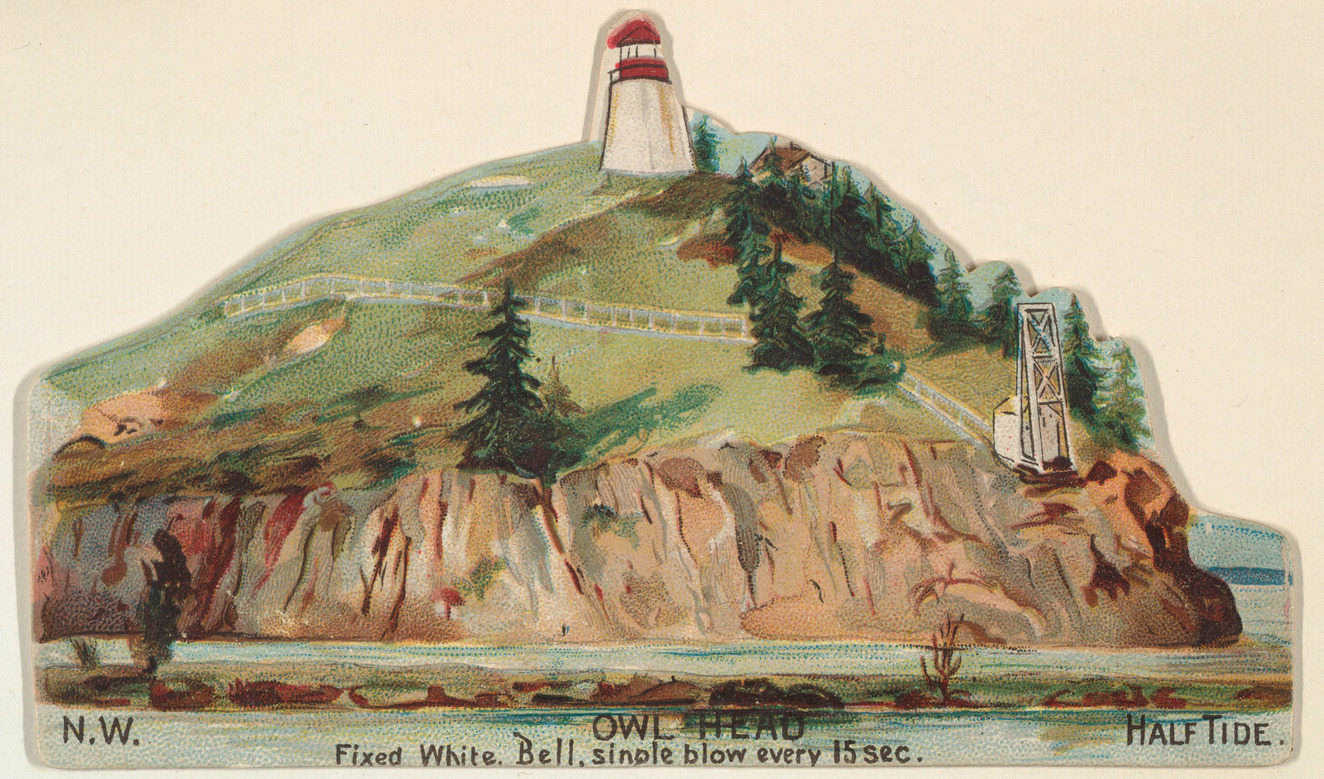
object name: print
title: Owl Head, from the Lighthouses series (N119) issued by Duke Sons & Co. to promote Honest Long Cut Tobacco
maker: w. duke, sons & co.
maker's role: publisher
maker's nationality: american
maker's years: 1870-1920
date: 1889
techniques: color lithograph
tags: towers